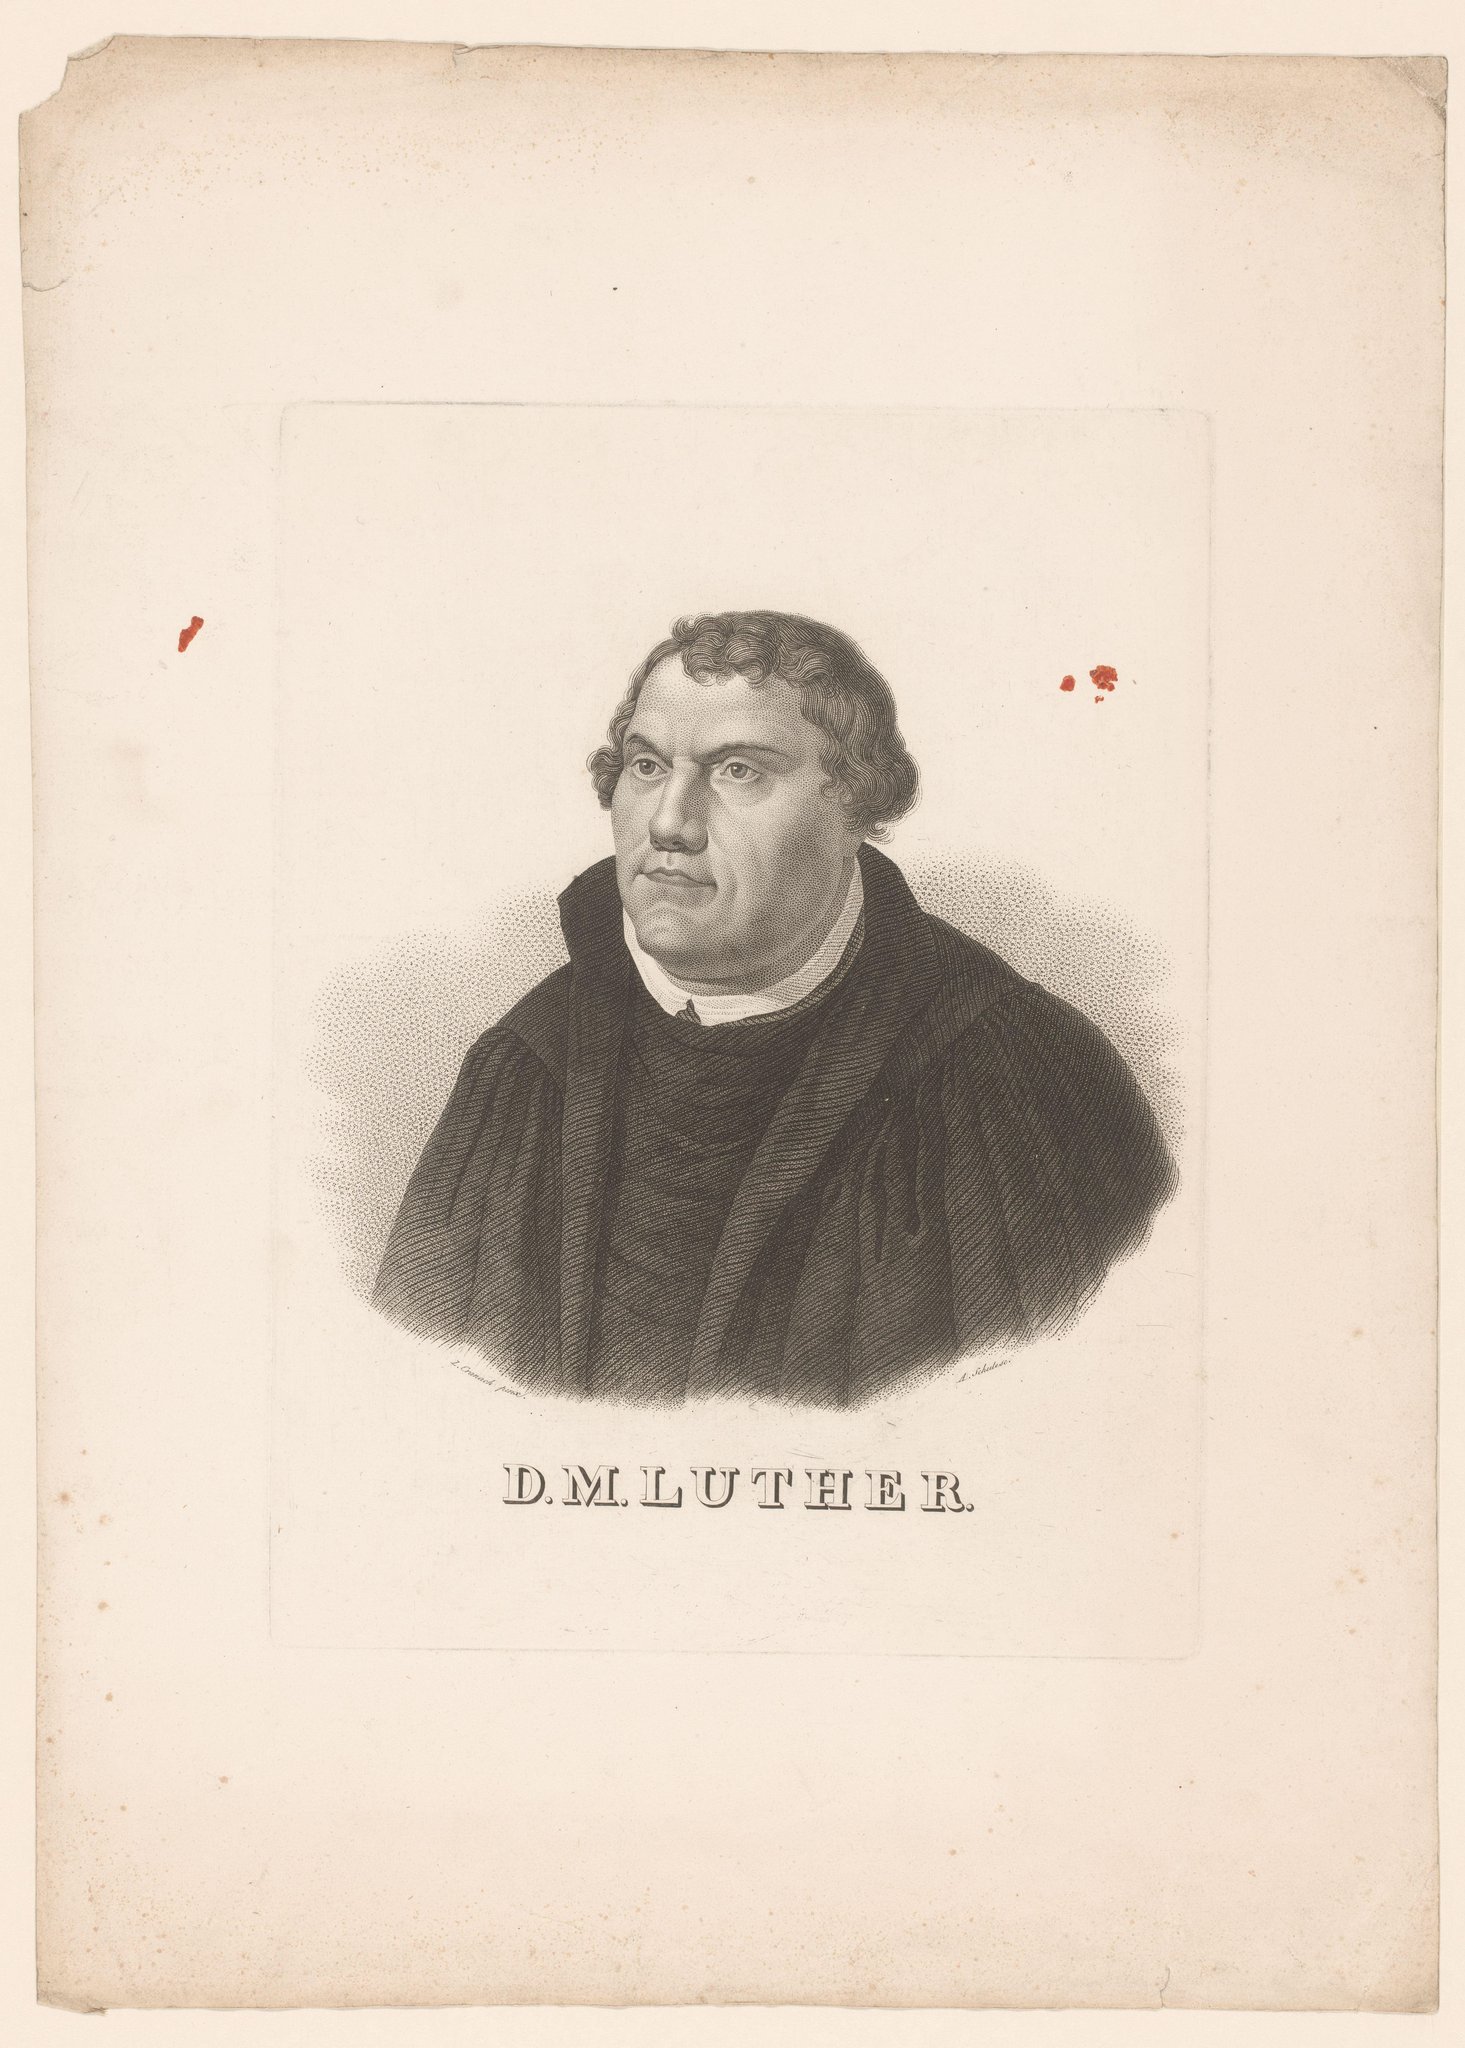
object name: print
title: Portret van Martin Luther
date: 1811-1875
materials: paper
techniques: engraving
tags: priest, martin luther, historical persons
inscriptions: collector's mark: Lugt 2228